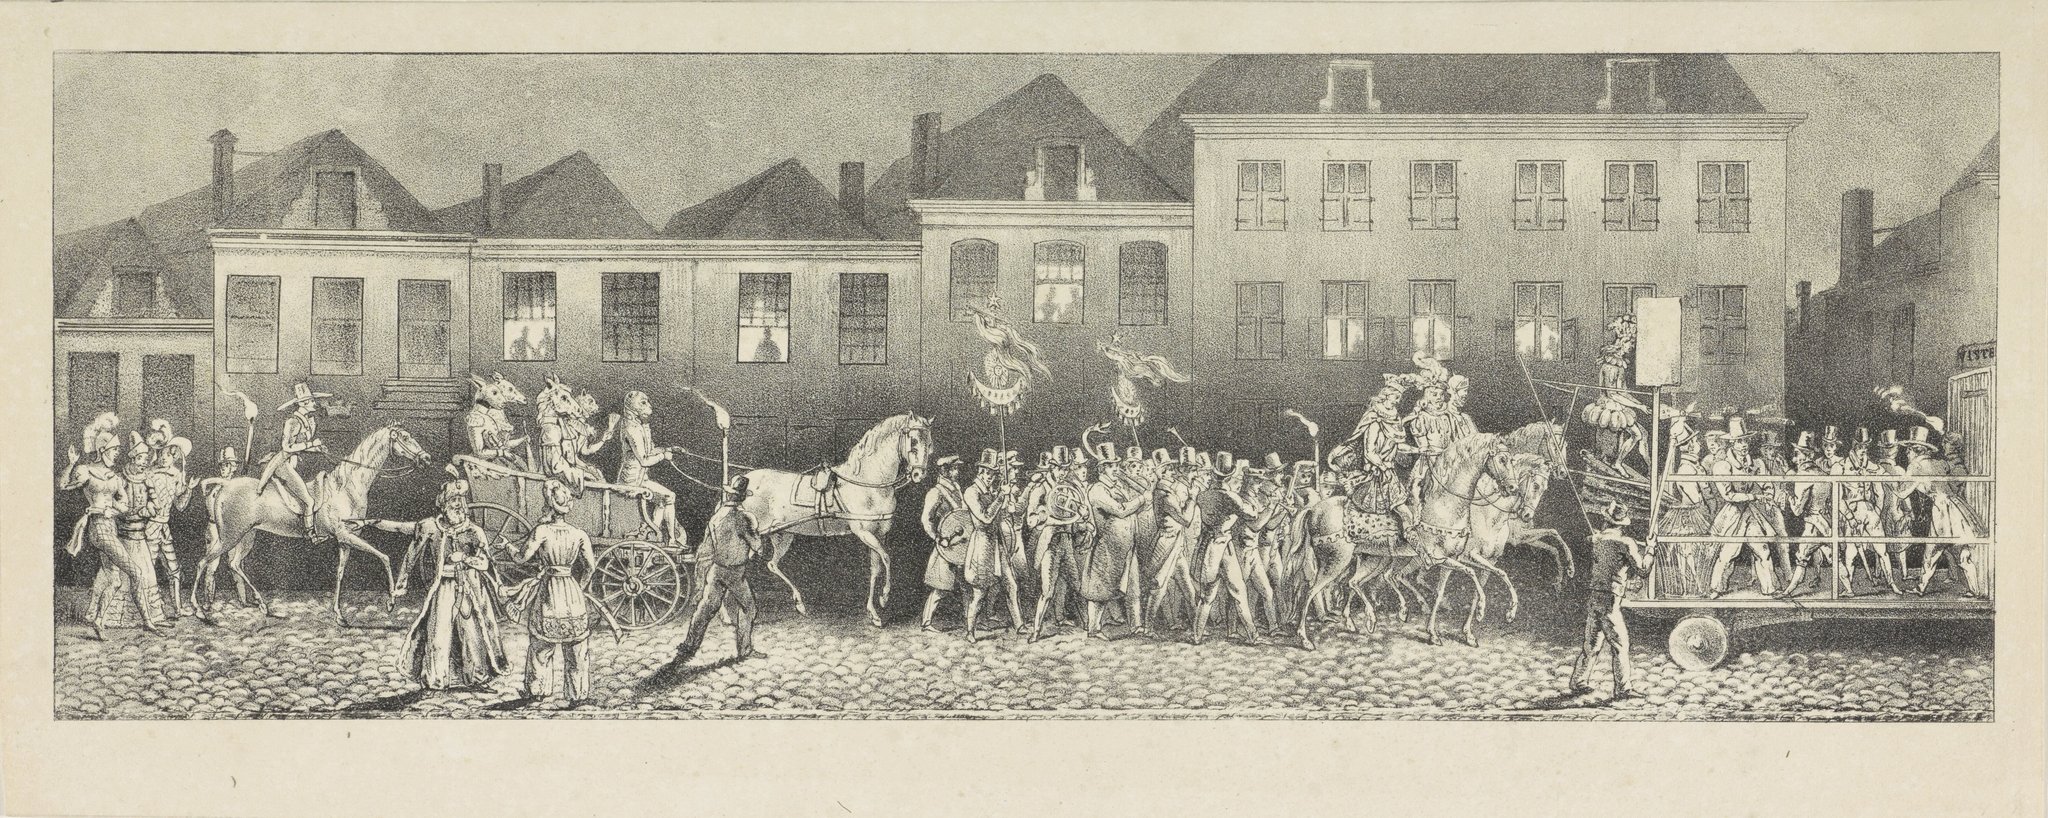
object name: print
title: Maskerade van Utrechtse studenten op de Dies Natalis, 1829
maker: johannes paulus houtman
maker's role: bookseller, print maker, printer, publisher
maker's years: 1803-1845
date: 1829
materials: paper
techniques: lithograph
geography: netherlands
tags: students' pageant, masquerade, masked ball, utrecht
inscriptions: collector's mark: Lugt 2228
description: Optocht in maskerade van Utrechtse studenten ter viering van de Dies Natalis van de universiteit van Utrecht op 26 maart 1829. Plaat 4: Stoet met een praalwagen, muziekkorps en een kar met studenten met dierenmaskers. Onderdeel van een groep van zeven platen die samen een lange fries vormen.